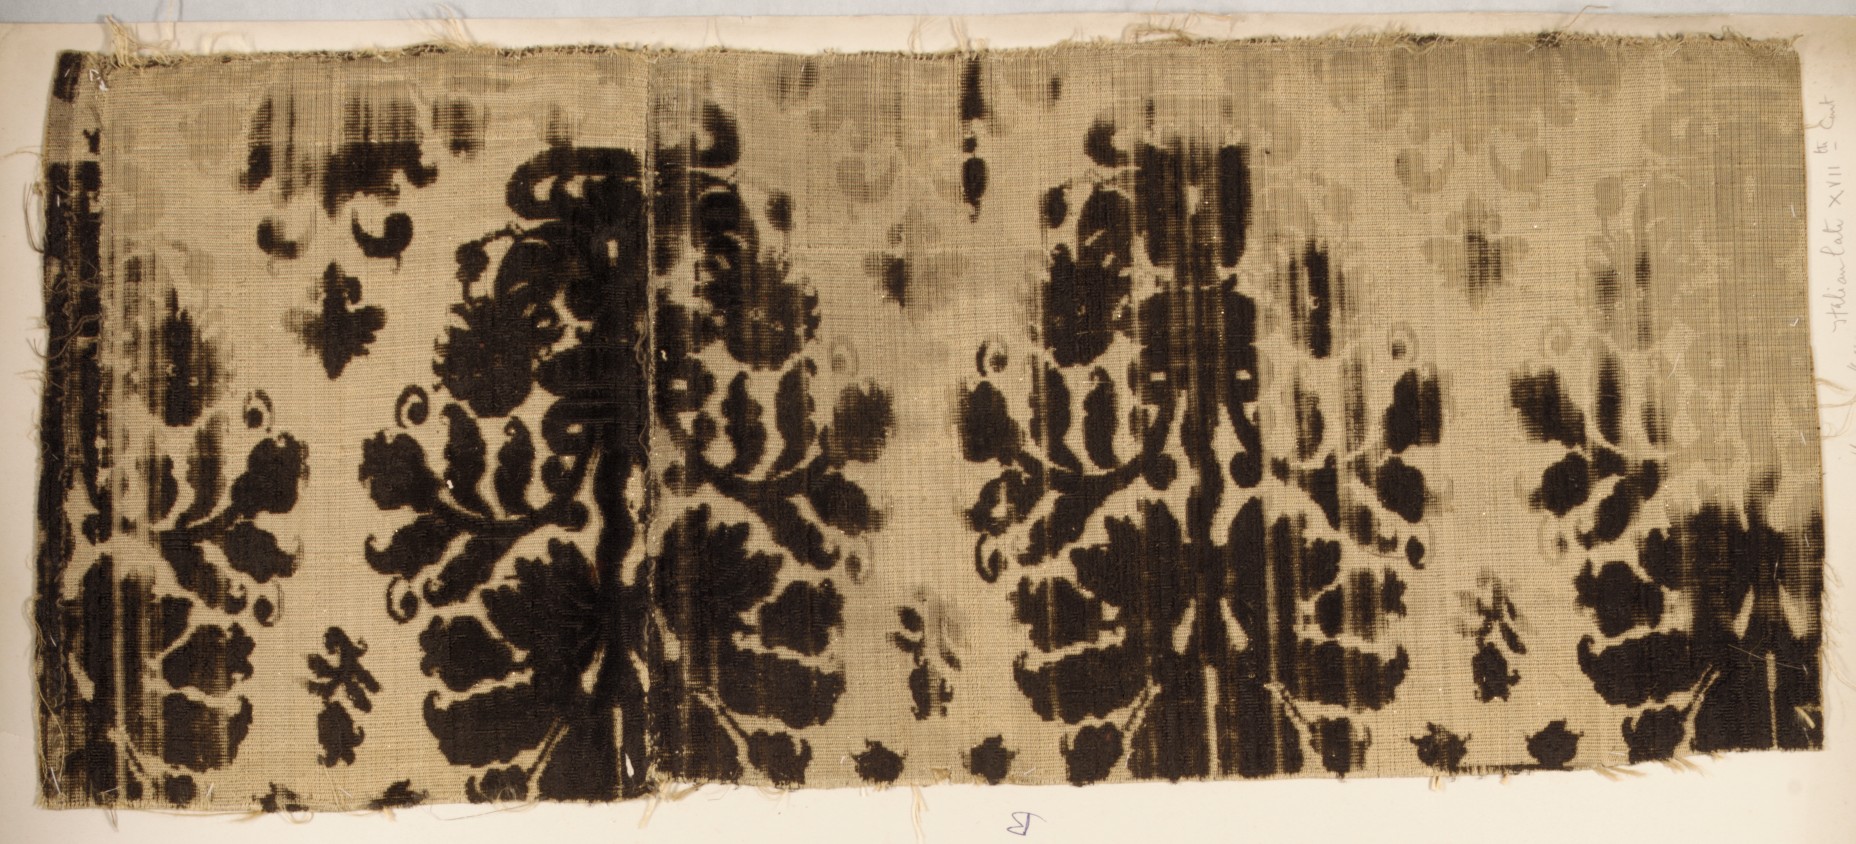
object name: fragment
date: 1601-1700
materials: metal thread, silk